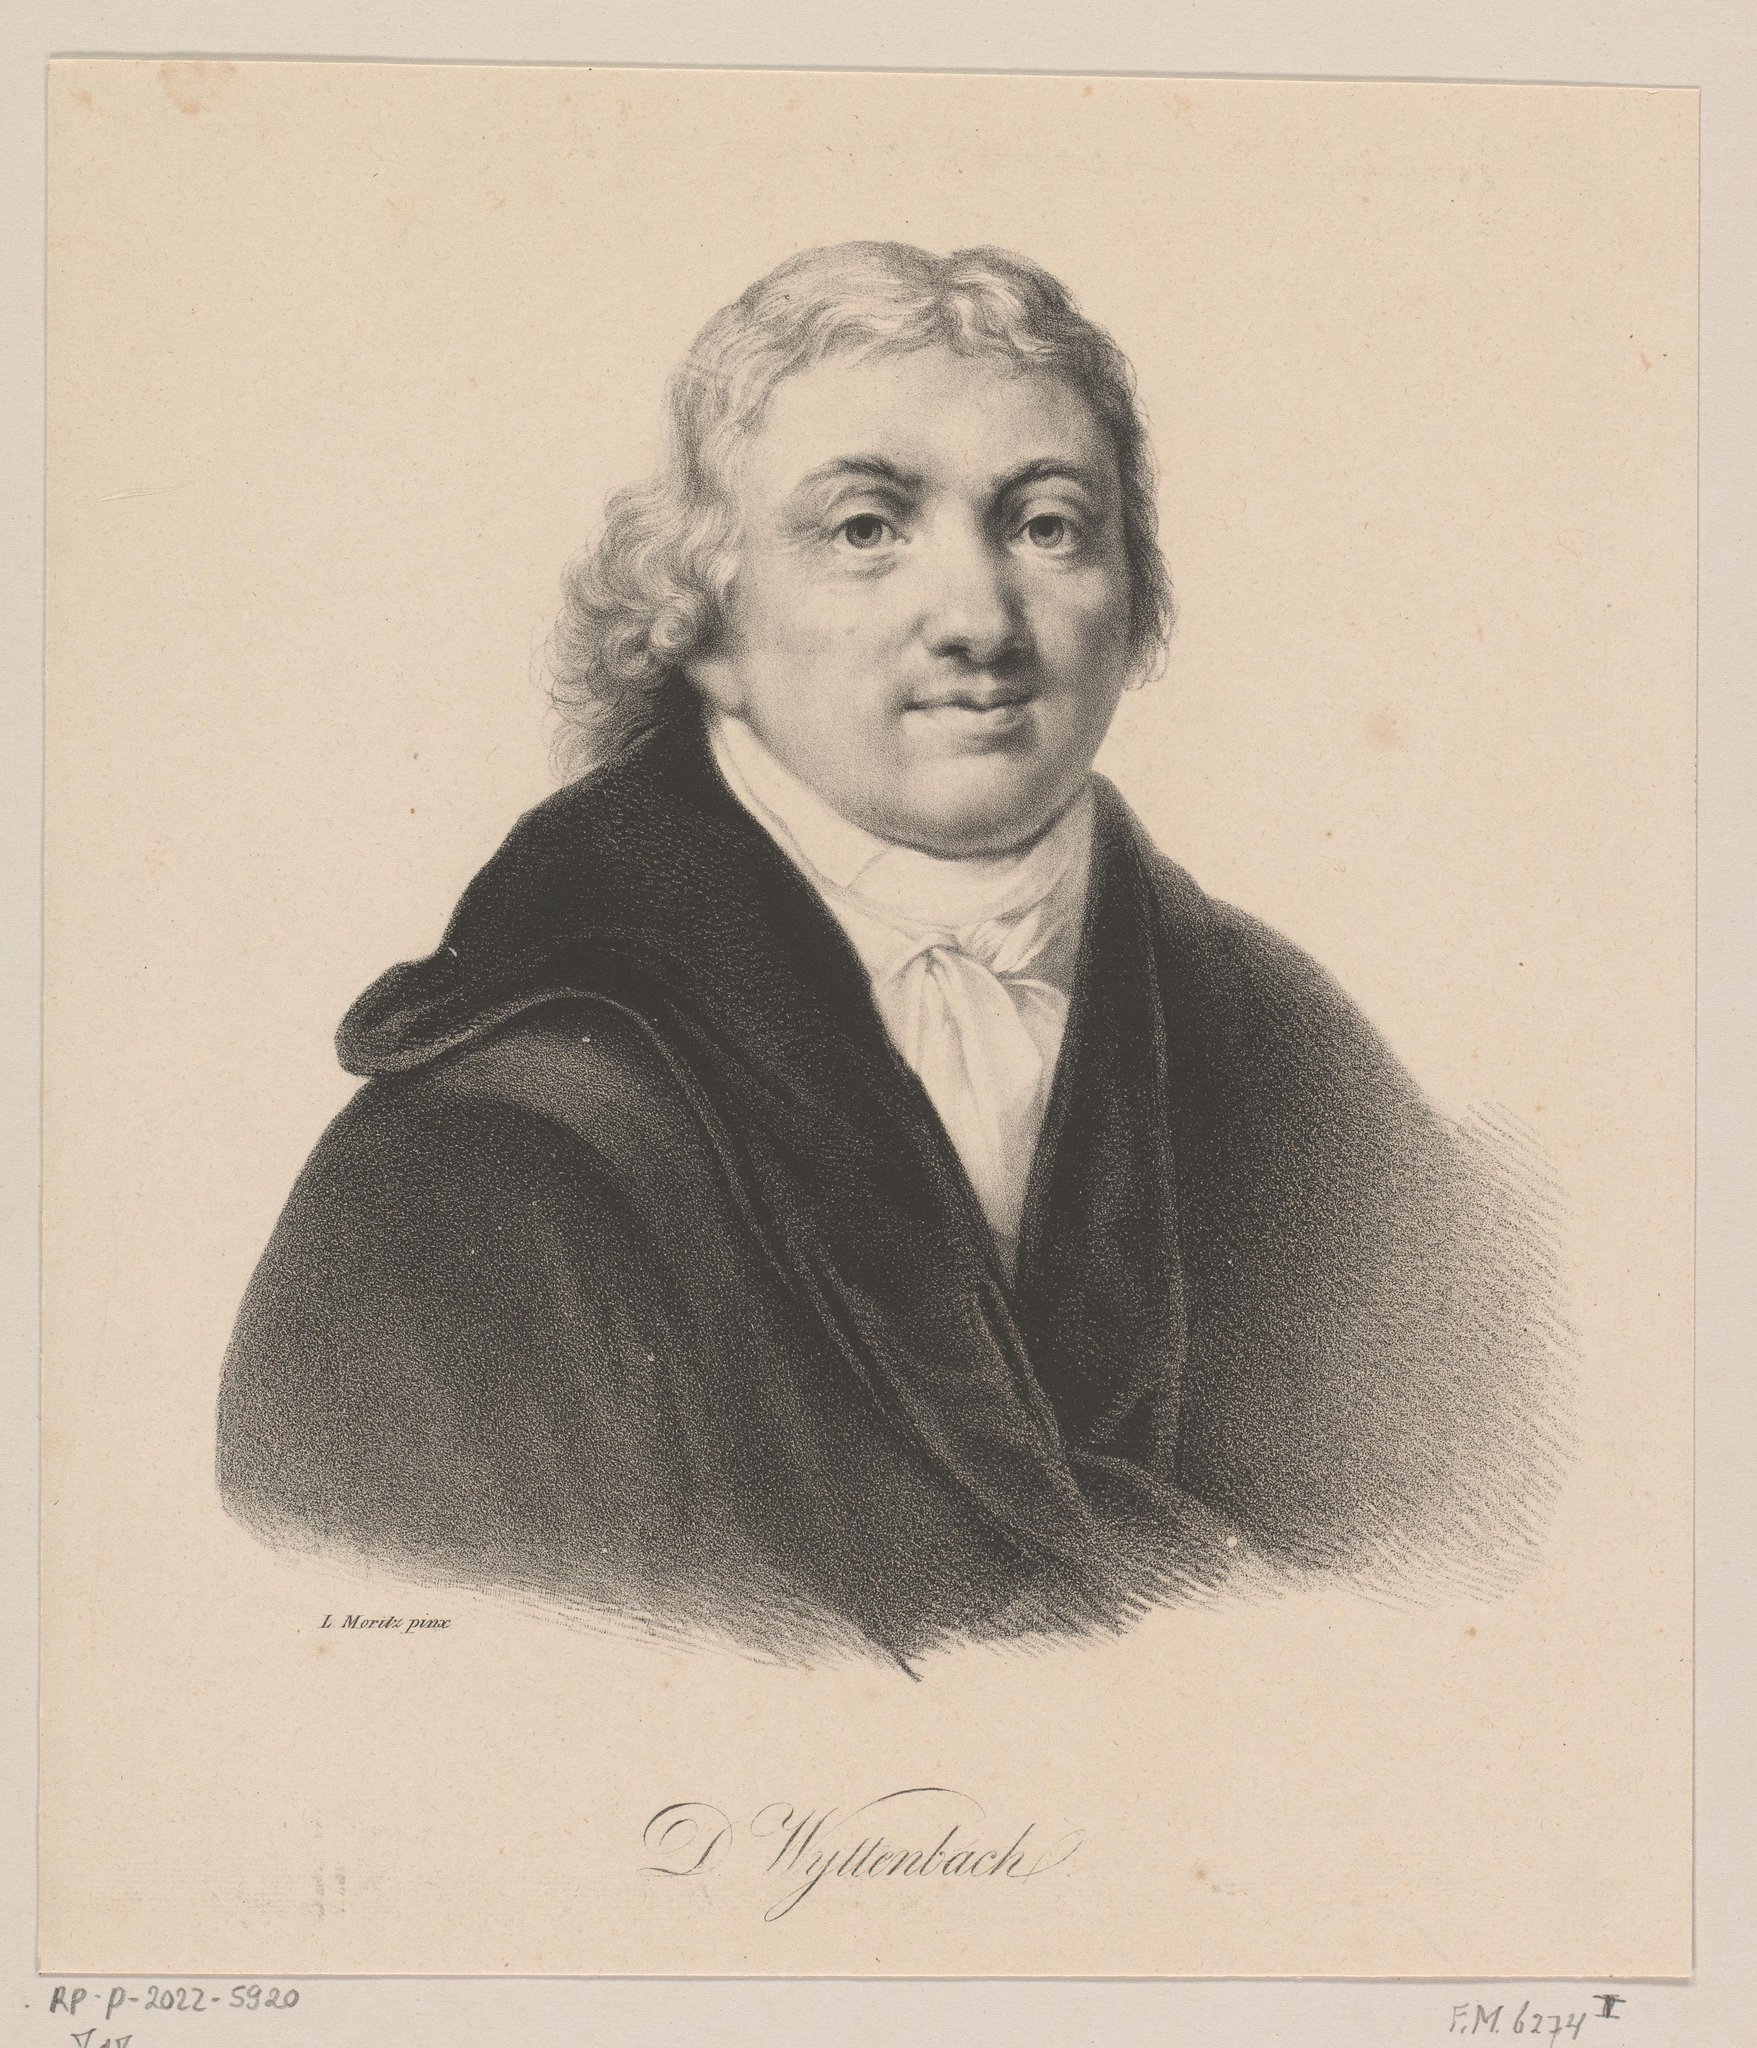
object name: print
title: Portret van Daniël Wyttenbach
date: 1801-1849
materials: paper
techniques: lithograph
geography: amsterdam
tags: historical persons, professor